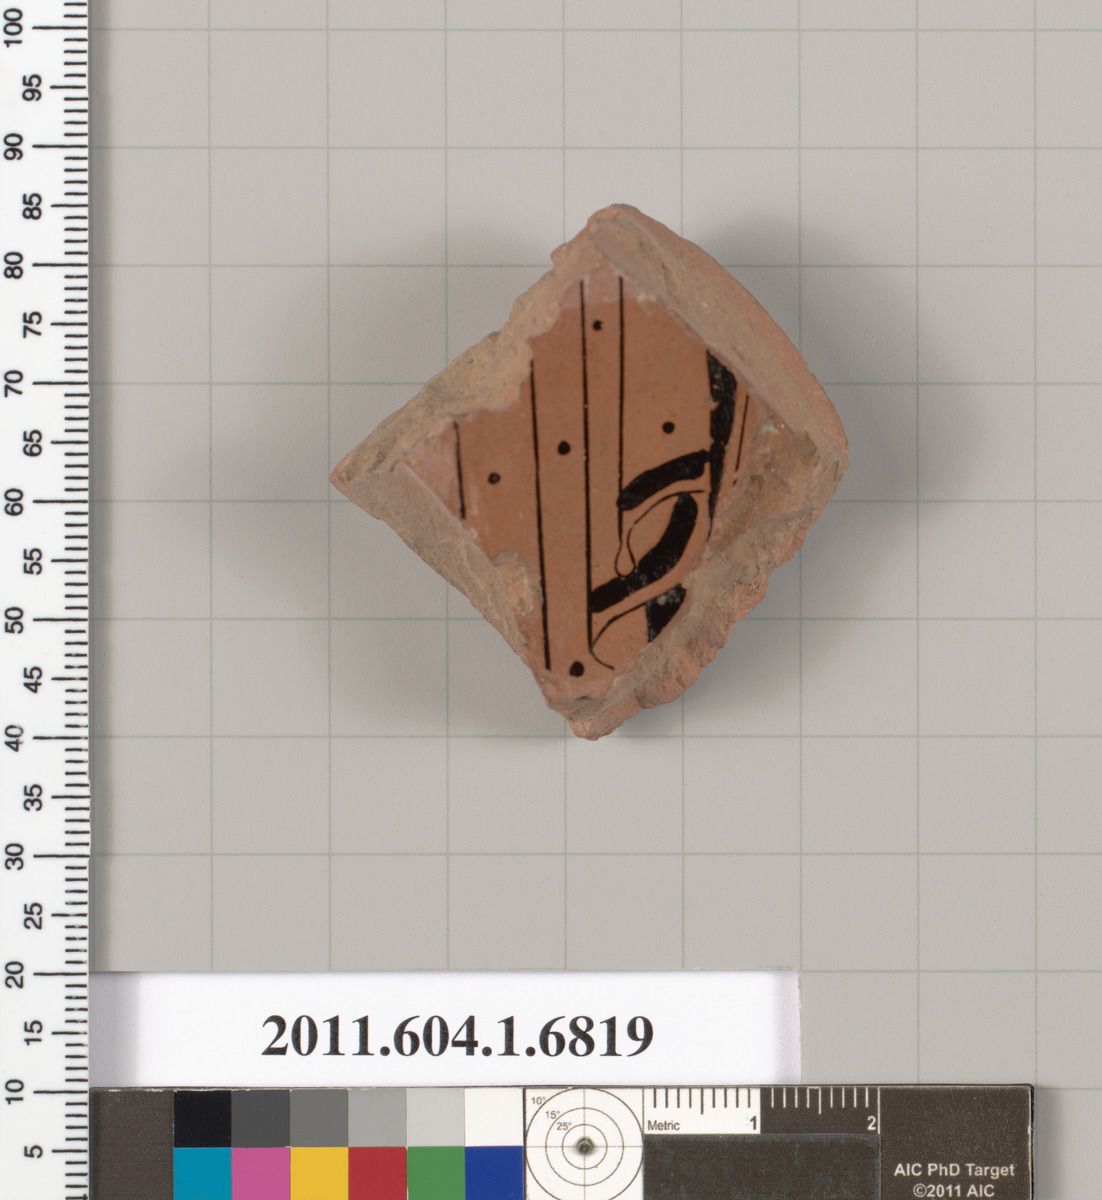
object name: kylix fragment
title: Terracotta fragment of a kylix (drinking cup)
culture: greek, attic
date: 490-470 BCE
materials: terracotta